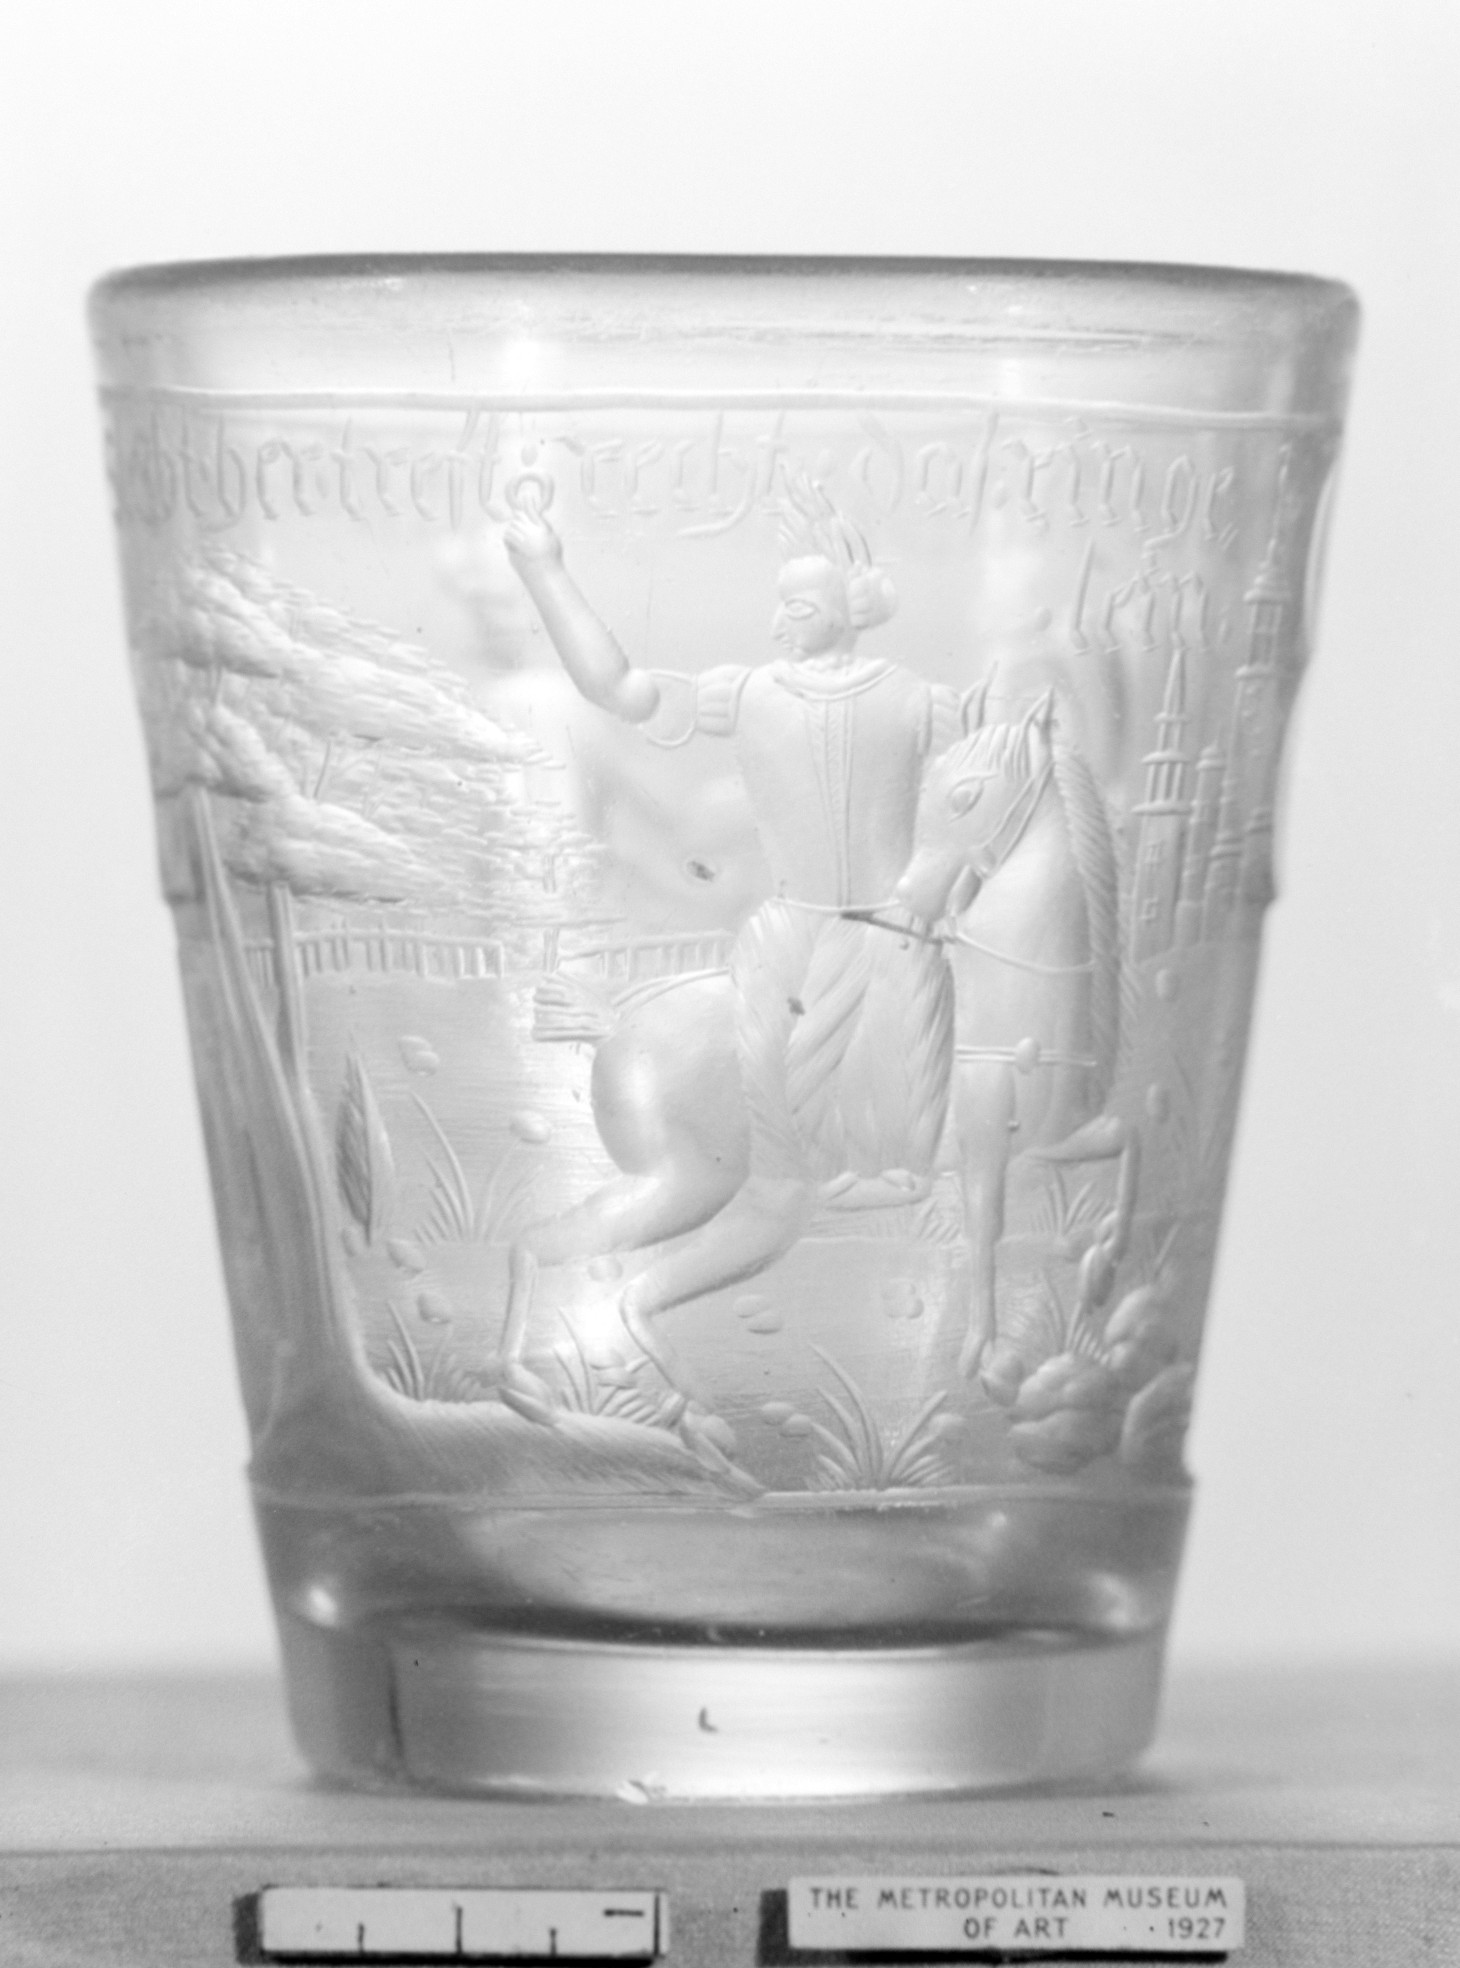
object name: beaker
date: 1634-1666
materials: glass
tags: human figures,horses